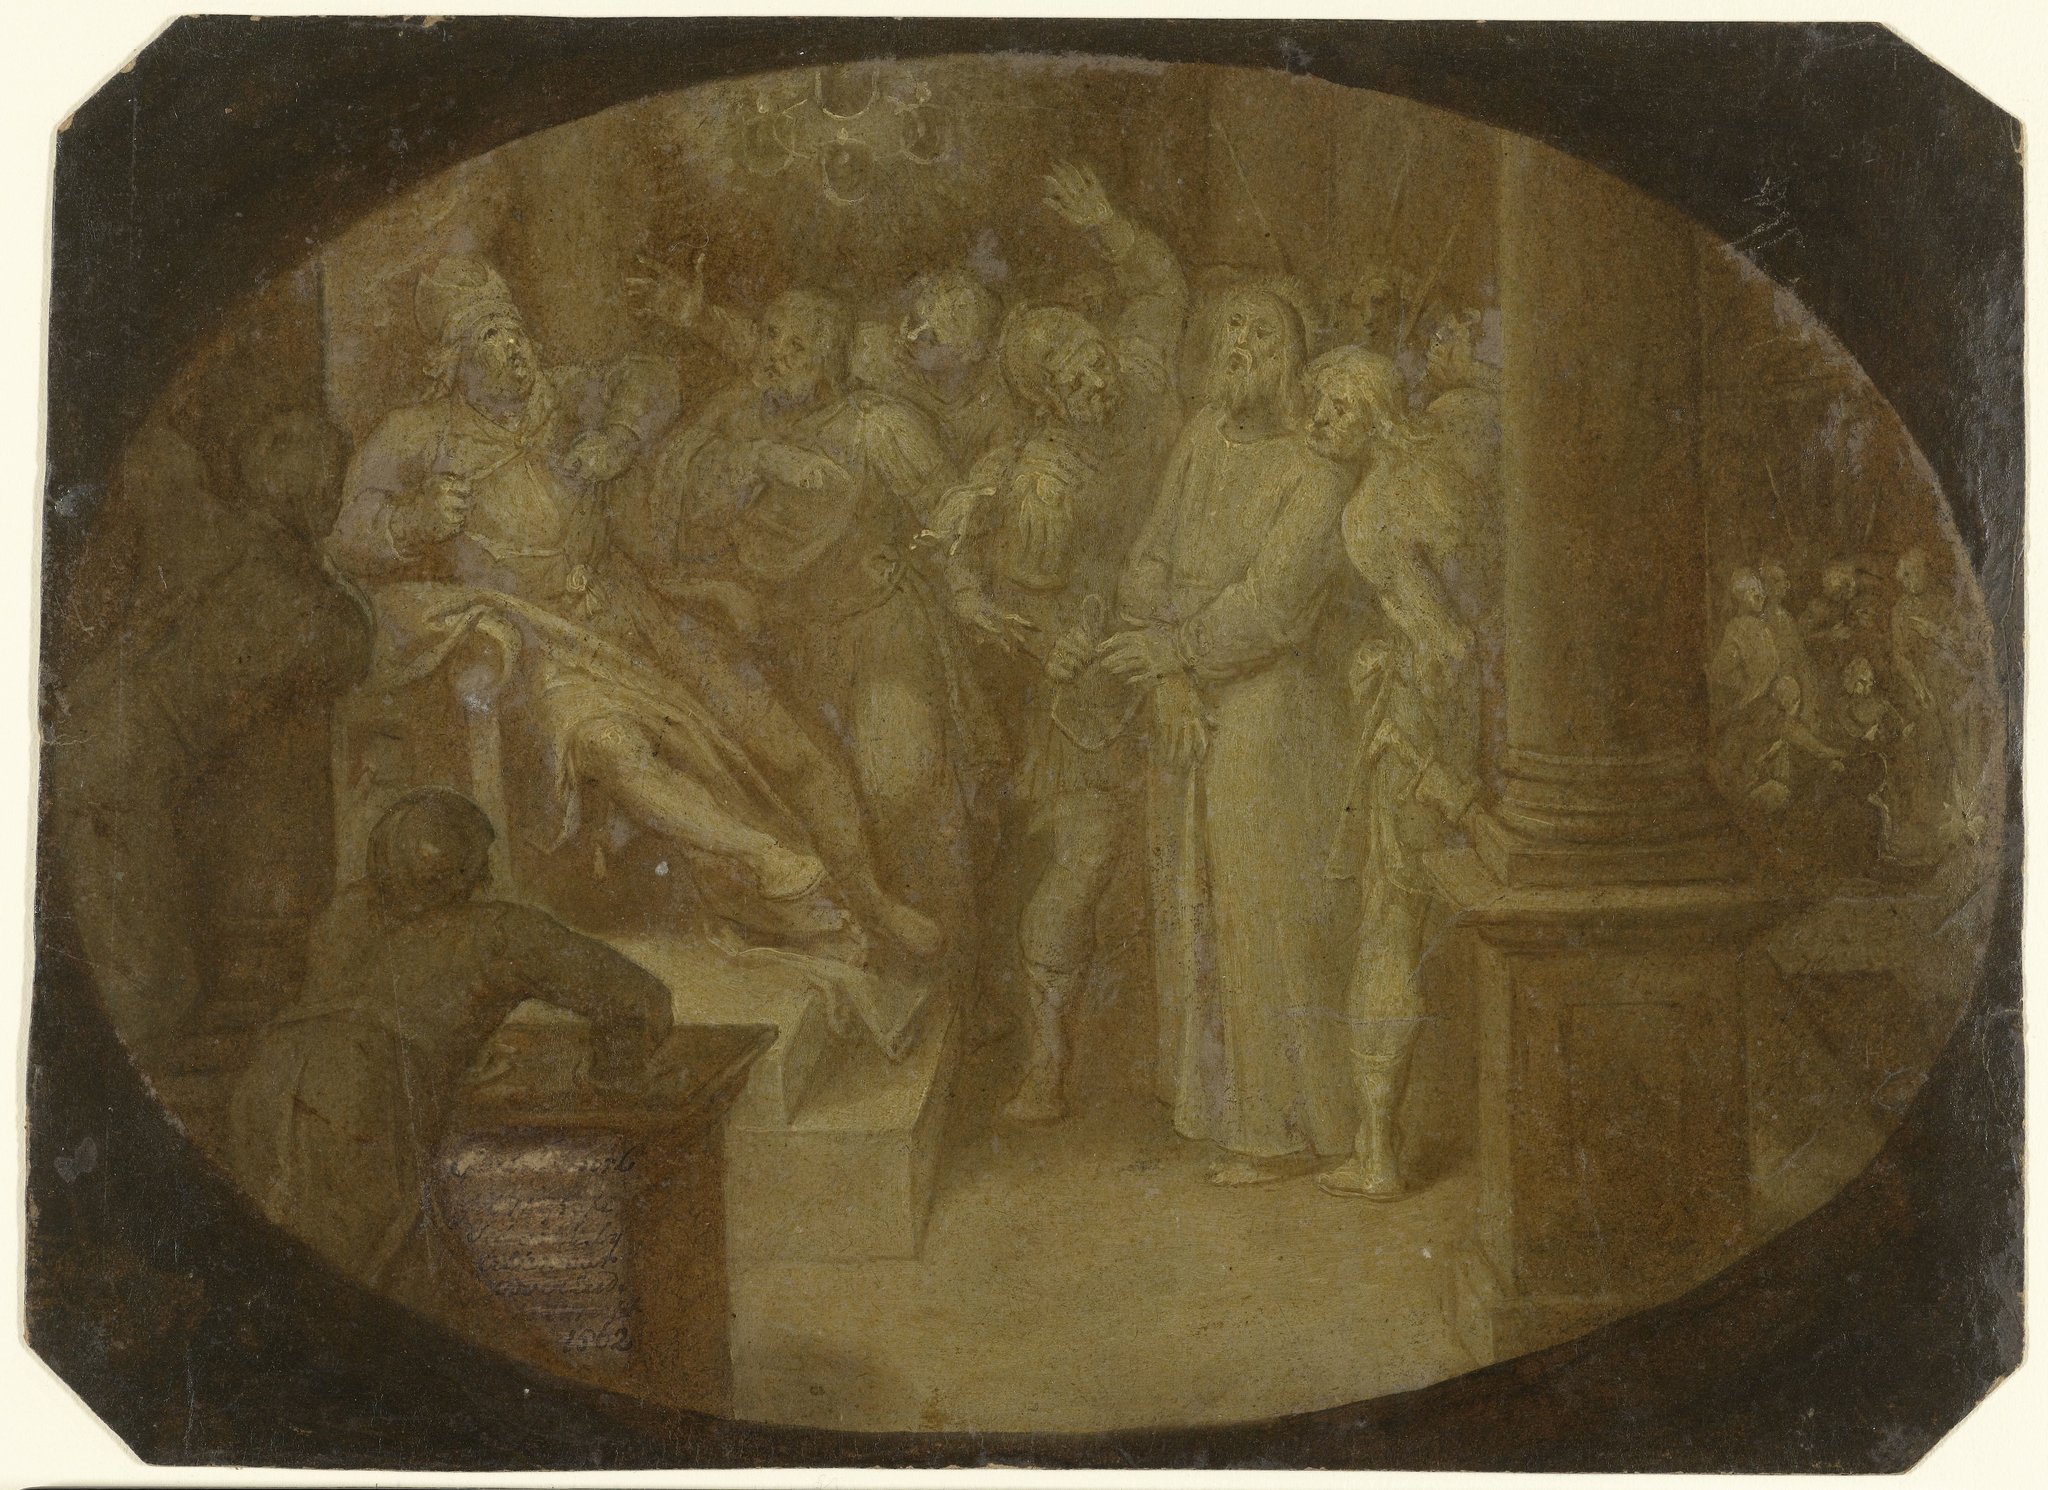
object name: drawing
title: Christus voor Kajafas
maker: otto van veen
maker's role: draughtsman, painter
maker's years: 1556-1629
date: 1566-1629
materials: oil, paper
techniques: grisaille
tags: christ before pontius pilate (matthew 27:11-26; mark 15:2-15; luke 23:2-7, 23:13-25; john 18:28 - 19:16), caiaphas tearing his clothes ~ trial of christ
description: Christus staat voor Kajafas. Kajafas scheurt zijn kleren.